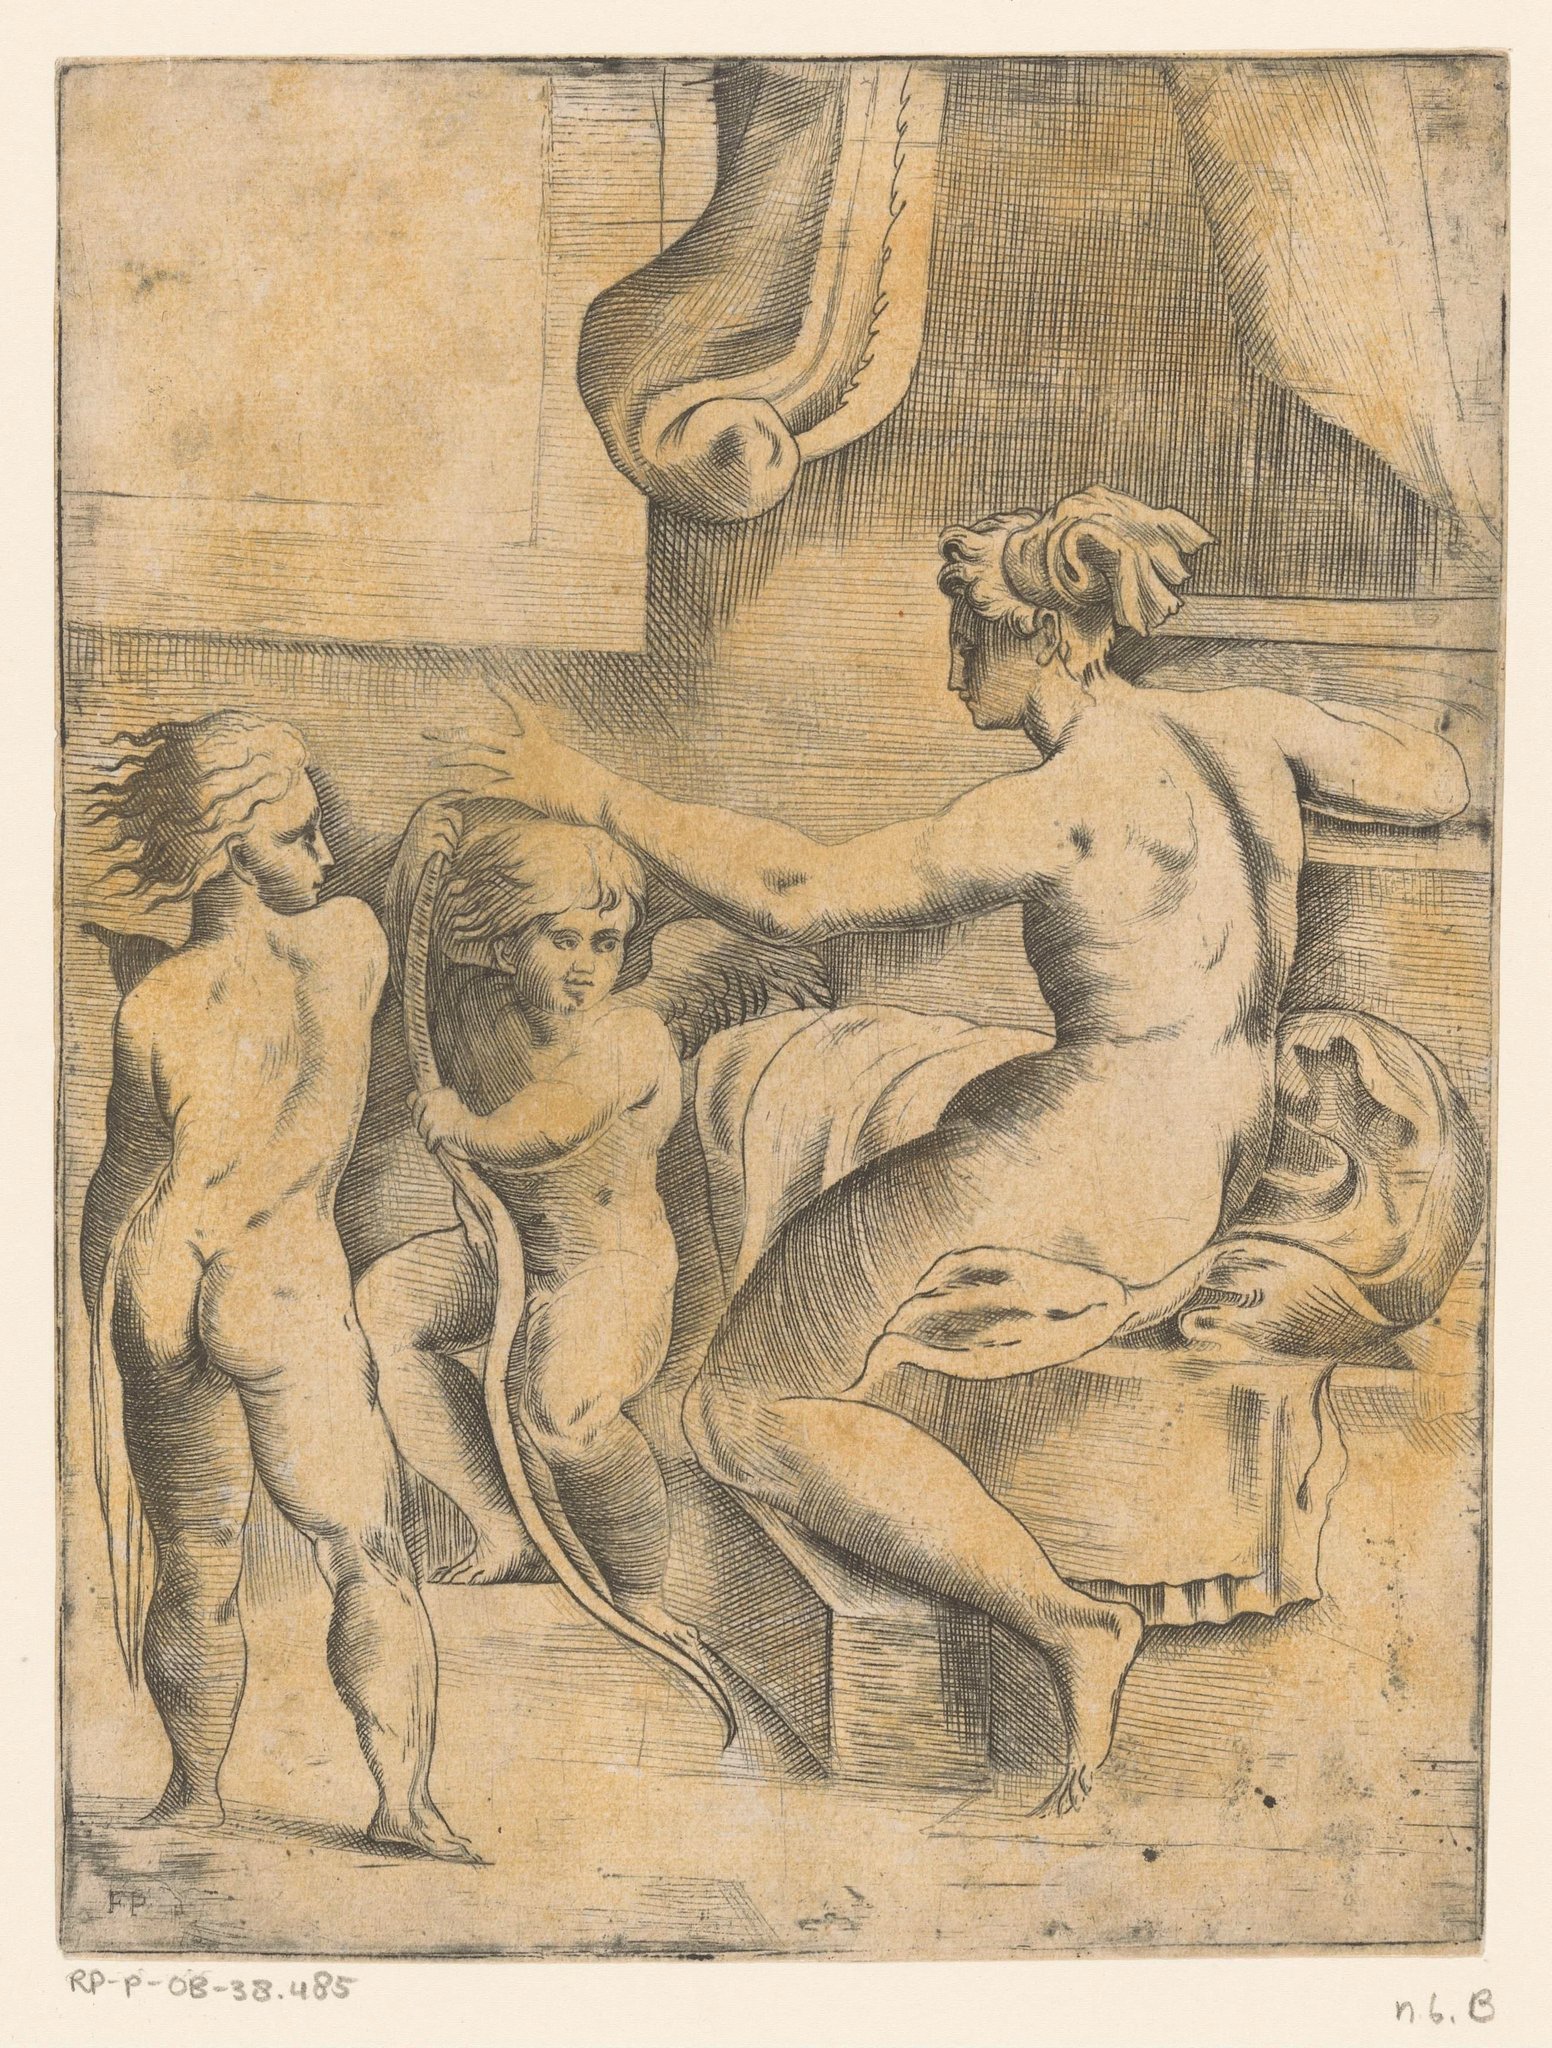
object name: print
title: Venus met twee putti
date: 1500-1599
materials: paper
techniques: engraving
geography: italy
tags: cupids: 'amores', 'amoretti', 'putti', venus and cupid (cupid not being mere attribute)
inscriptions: collector's mark: Lugt 240, inscription: ‘Primaticcio’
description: Venus zit en probeert de boog van een putto (mogelijk Amor) af te pakken. Links een tweede putto op de rug gezien.